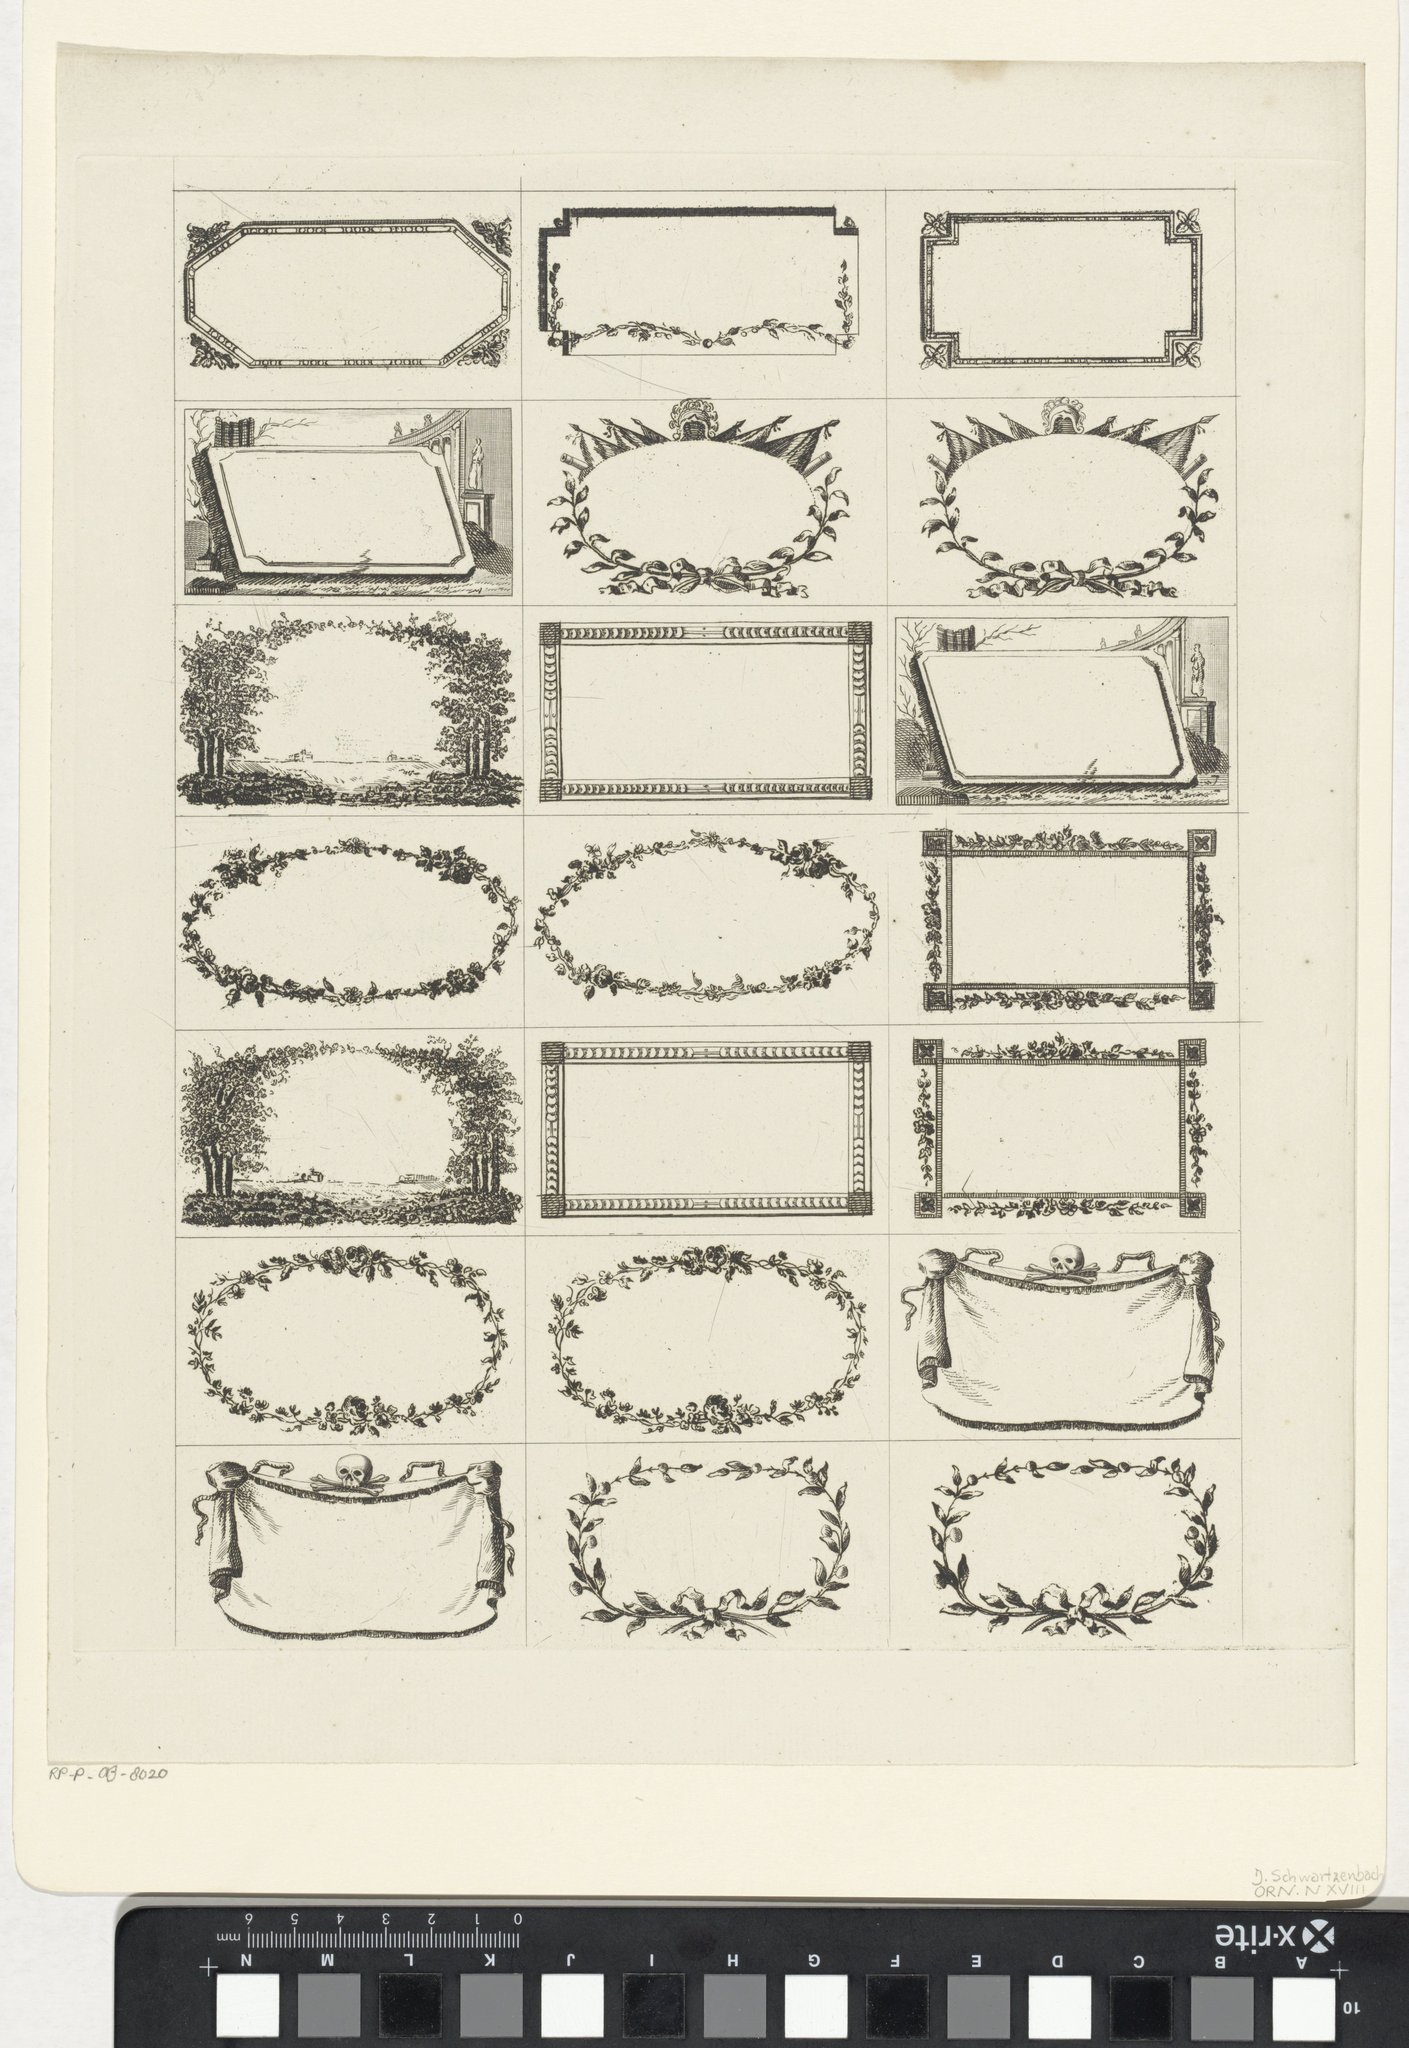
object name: ornament print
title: Ontwerp voor 21 vignetten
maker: jacob schwartzenbach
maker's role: draughtsman, painter, print maker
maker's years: 1763-1805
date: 1773-1805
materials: paper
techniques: etching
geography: veere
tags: ornaments ~ art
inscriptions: collector's mark: Lugt 2228